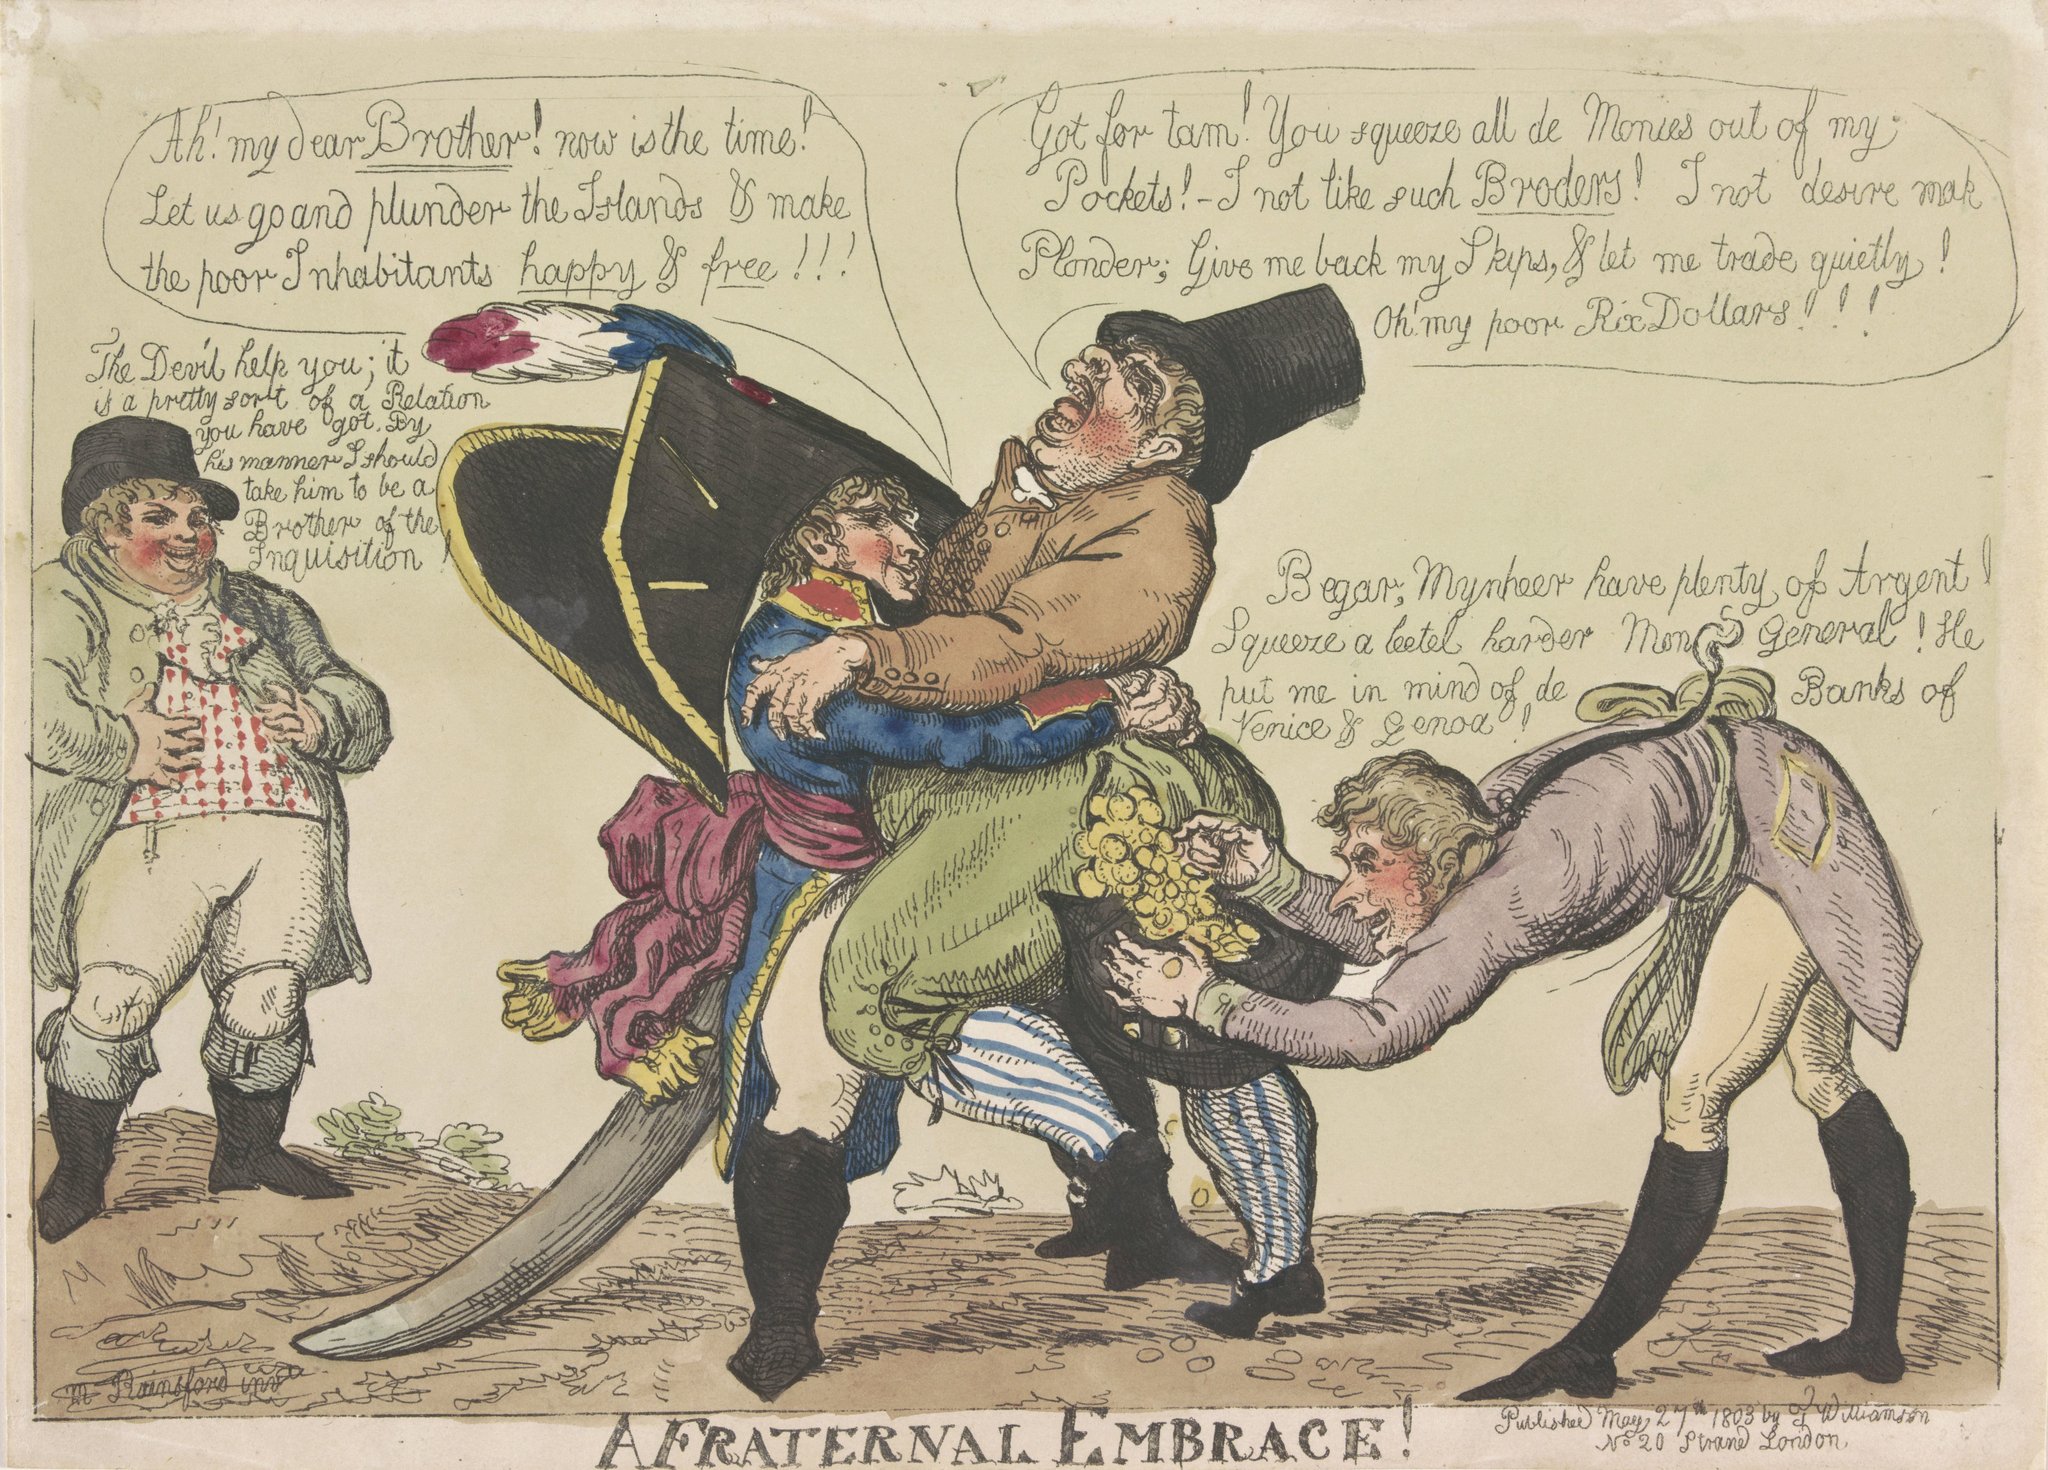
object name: cartoon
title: A Fraternal Embrace!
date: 1803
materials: paper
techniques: etching, hand coloring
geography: london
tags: napoleon i (emperor of the french), personifications of countries, nations, states, districts, etc.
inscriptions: collector's mark: Lugt 2228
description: Napoleon houdt een dikke Hollander vast en knijpt hem zo hard dat de geldstukken uit zijn zakken rollen. Een andere Fransman vangt de goudstukken op in zijn hoed en vraagt de generaal nog harder te knijpen. Links kijkt John Bull (Groot-Brittannië) lachend toe. Waarschijnlijk gerelateerd aan de voorwaarden van de Vrede van Amiens van 1802.